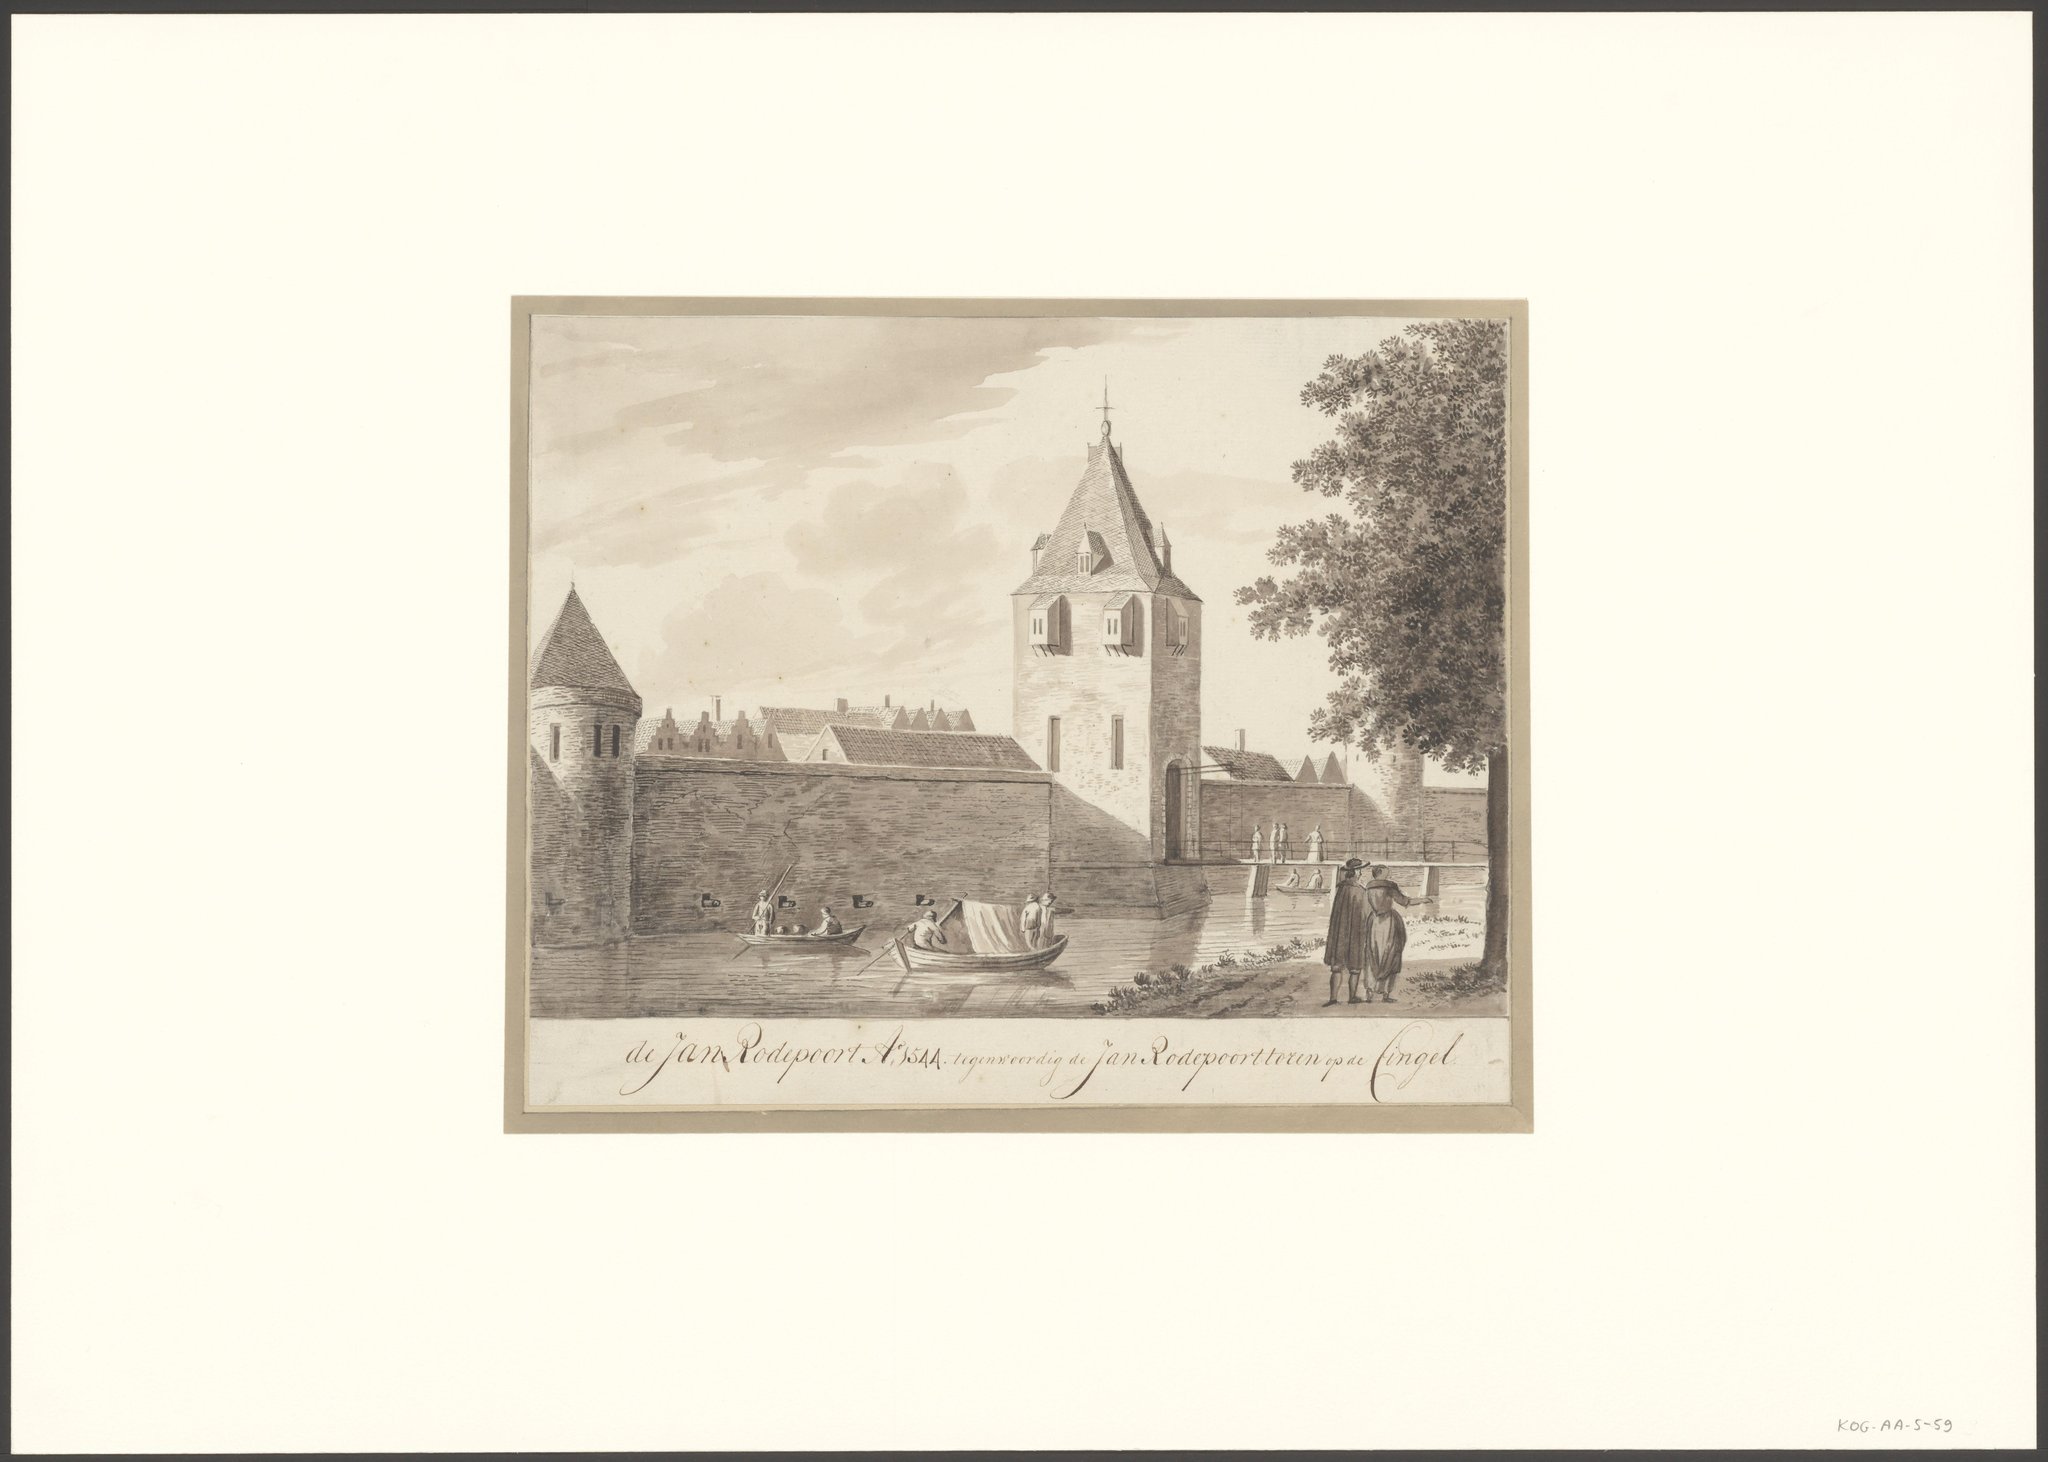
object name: drawing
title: Gezicht op de Jan Roodenpoort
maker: hendrik tavenier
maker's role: draughtsman, print maker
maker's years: 1734-1807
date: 1784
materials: ink, paper, pencil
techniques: brush, pen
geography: amsterdam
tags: city-view in general; 'veduta', canal, city-gate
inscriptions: signature, date and inscription: ‘Jan Roodepoortstooren te Amsterdam / 1784 / H. Tavenier’, inscription: ‘de Jan Rodepoort Ao 1544. tegenwoordig de Jan Rodepoorttoren op de Singel.’, number: ‘41’